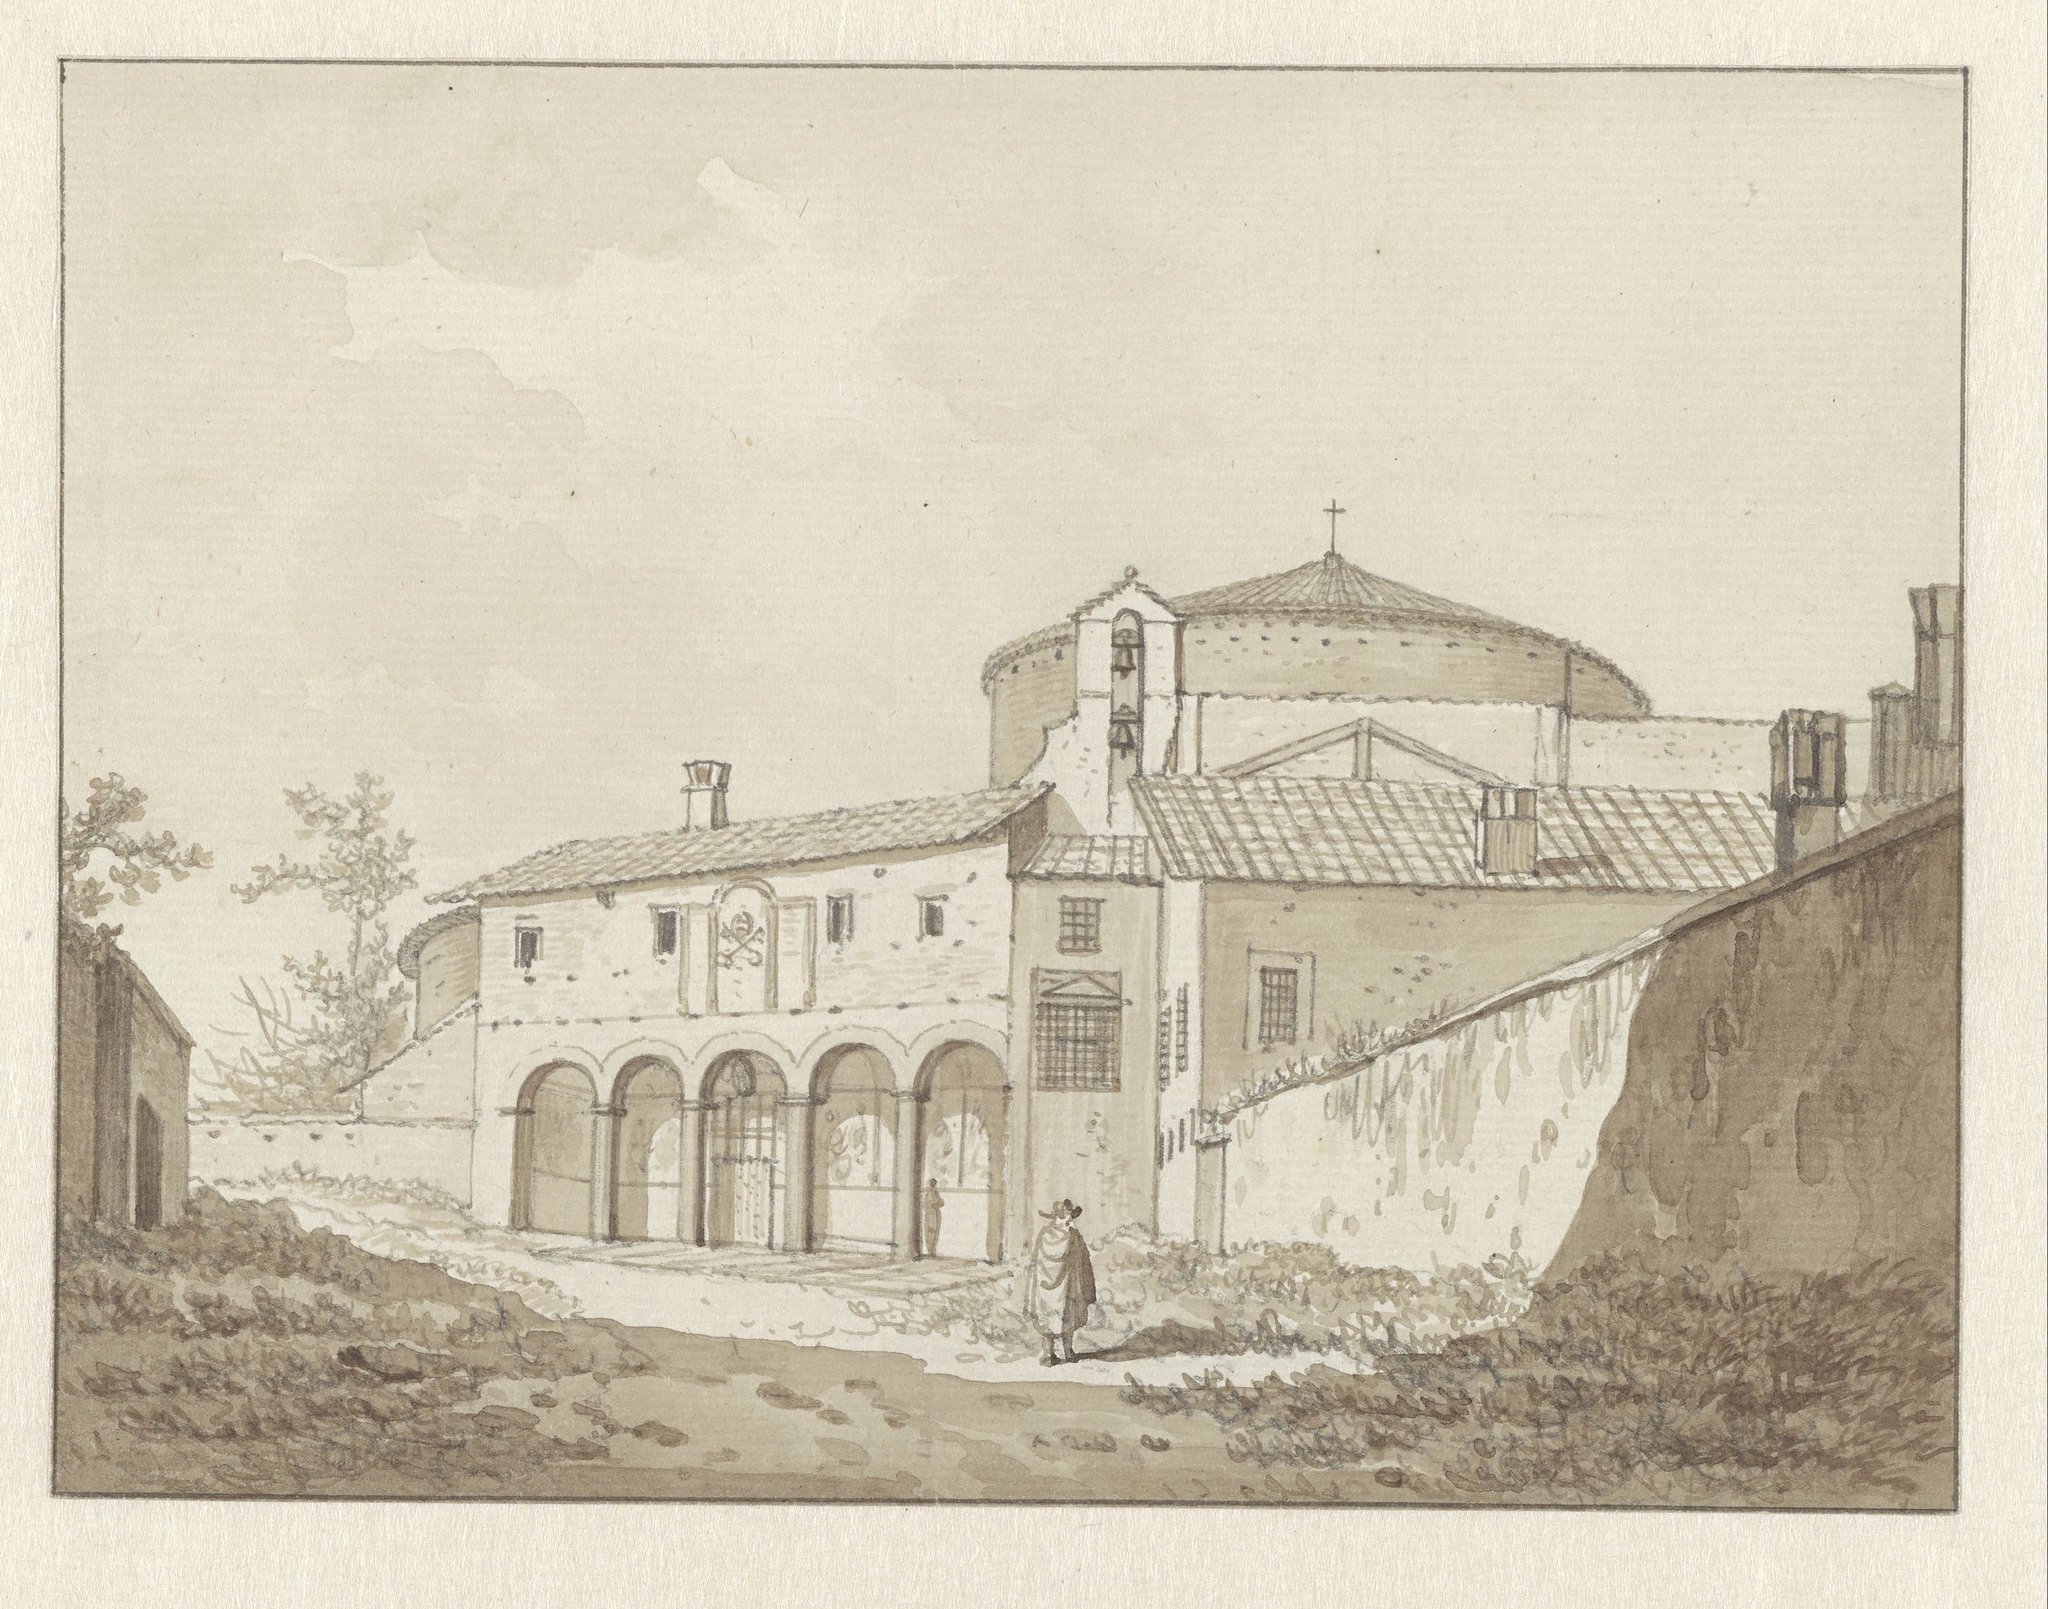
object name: drawing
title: De kerk van S.Stefano Rotondo in Rome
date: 1761-1817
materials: chalk, ink, paper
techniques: brush, pen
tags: church (exterior), rome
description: Tekening uit een groep tekeningen van landschappen en stadsgezichten in Italië (Rome, Tivoli, Civita Castellana en Pozzuoli).